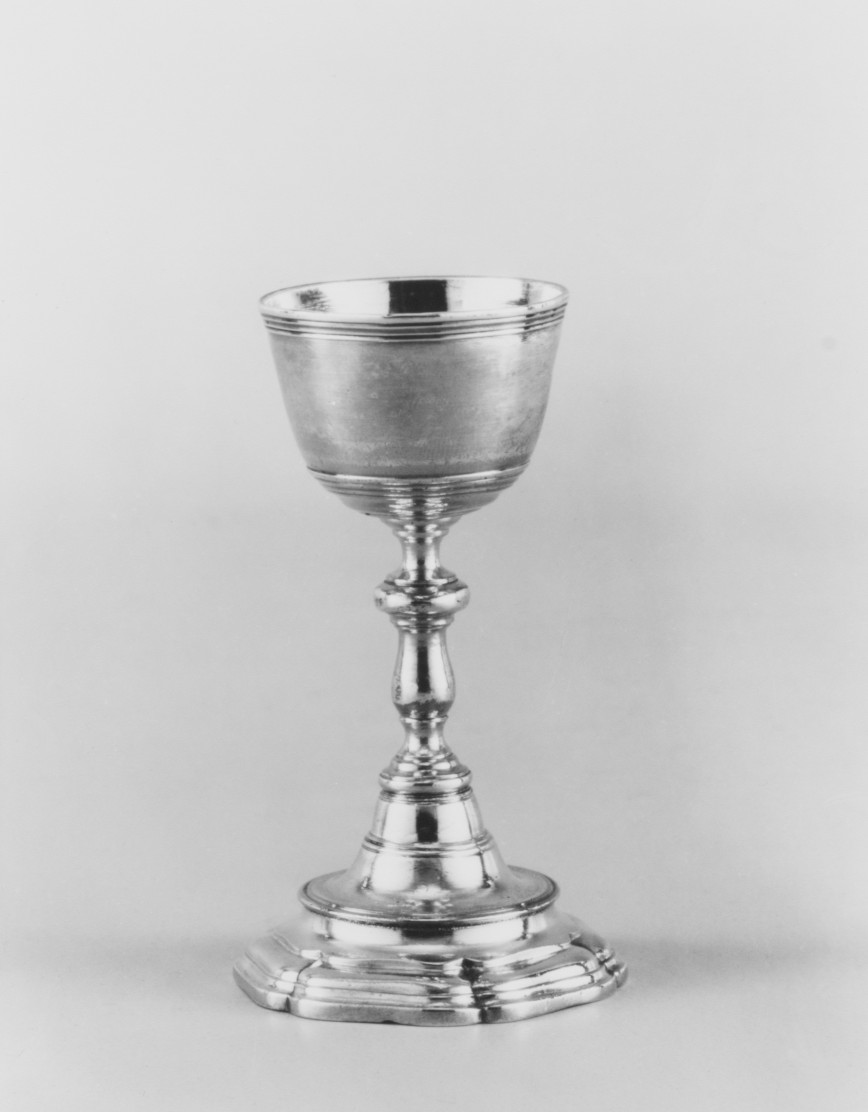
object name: egg cup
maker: michel ii delapierre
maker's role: maker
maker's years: 1707-1815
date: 1747-1748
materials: silver